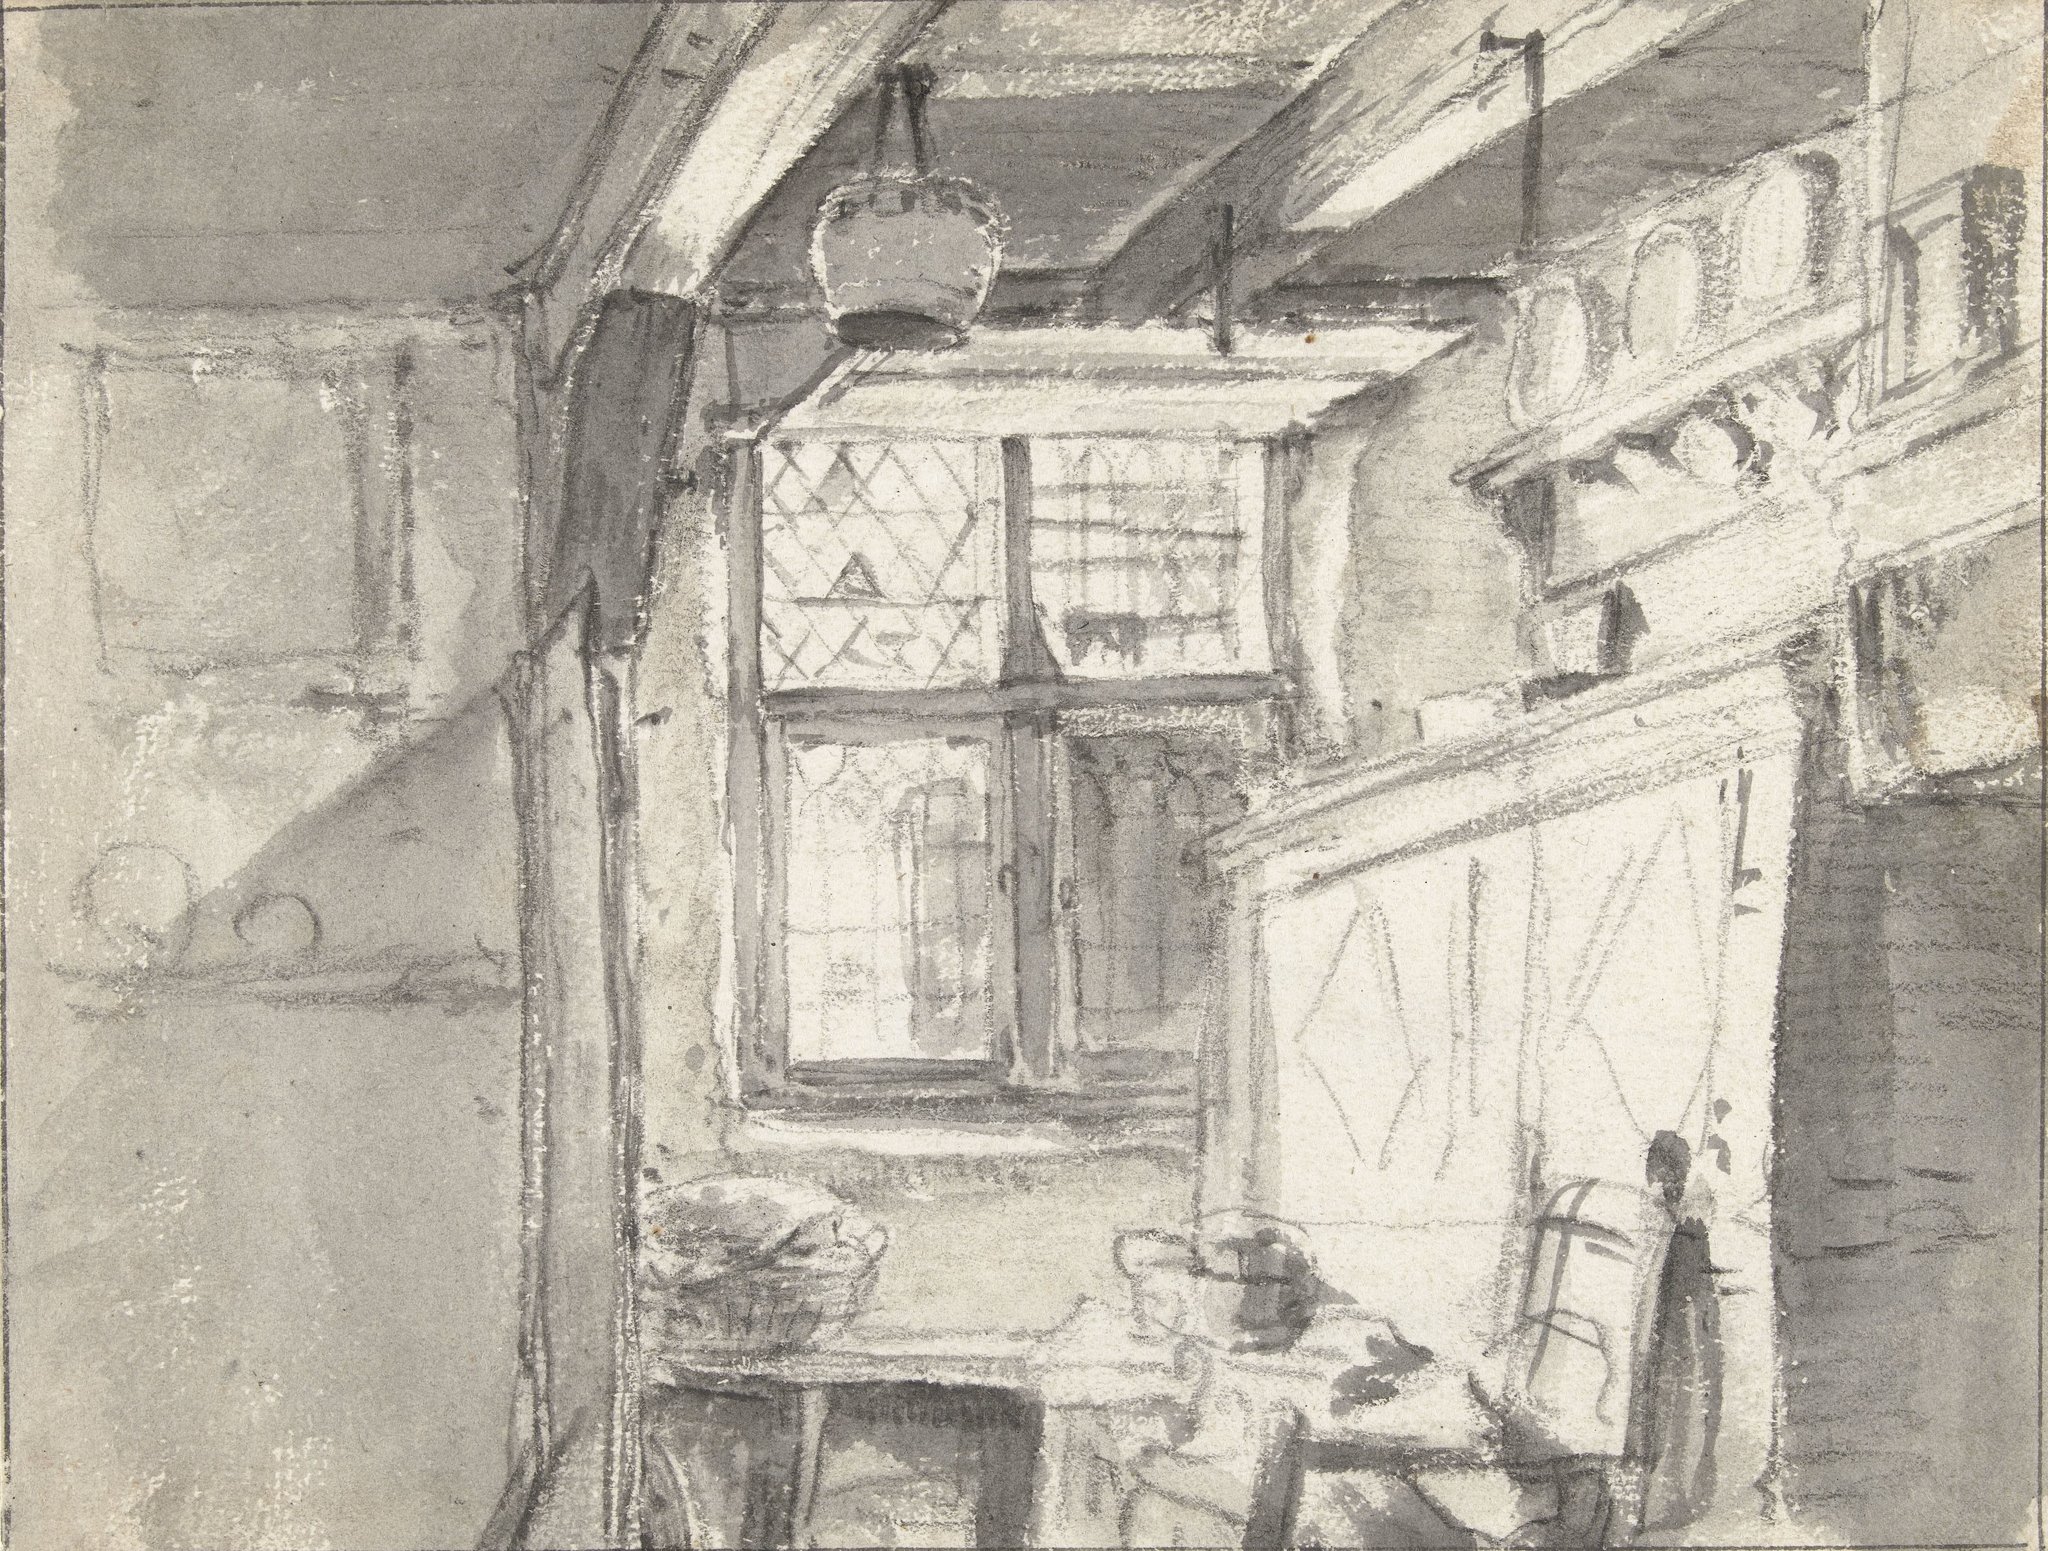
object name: drawing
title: Een binnenvertrek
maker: thomas wijck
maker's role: draughtsman, painter, print maker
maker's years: 1616-1677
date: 1626-1677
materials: chalk, paper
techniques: brush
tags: communal rooms